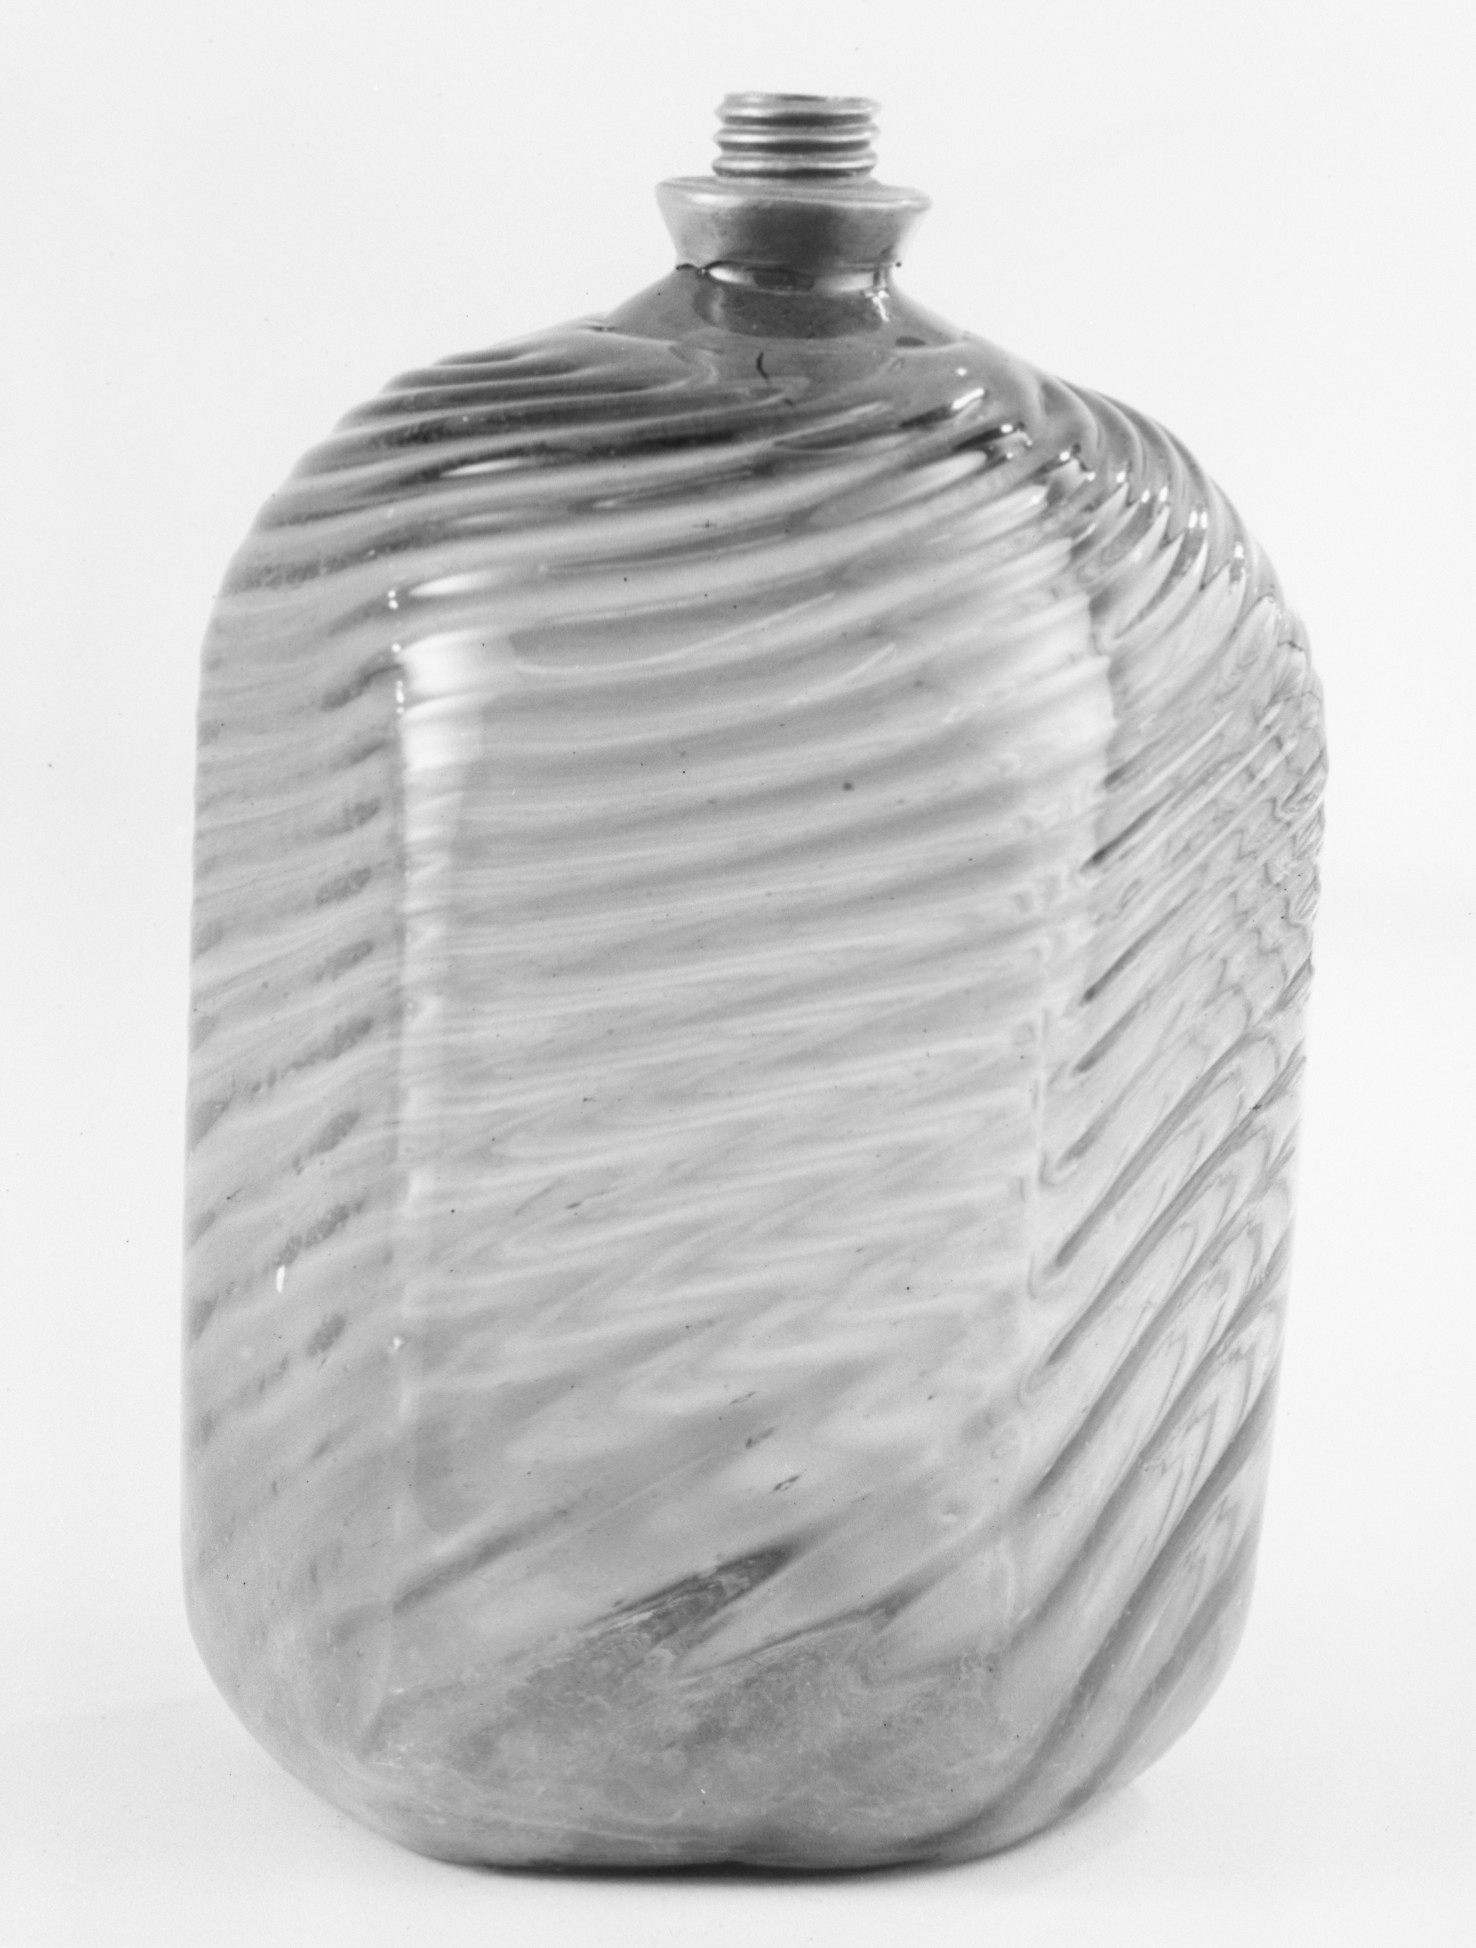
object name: bottle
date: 1701-1800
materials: glass, pewter